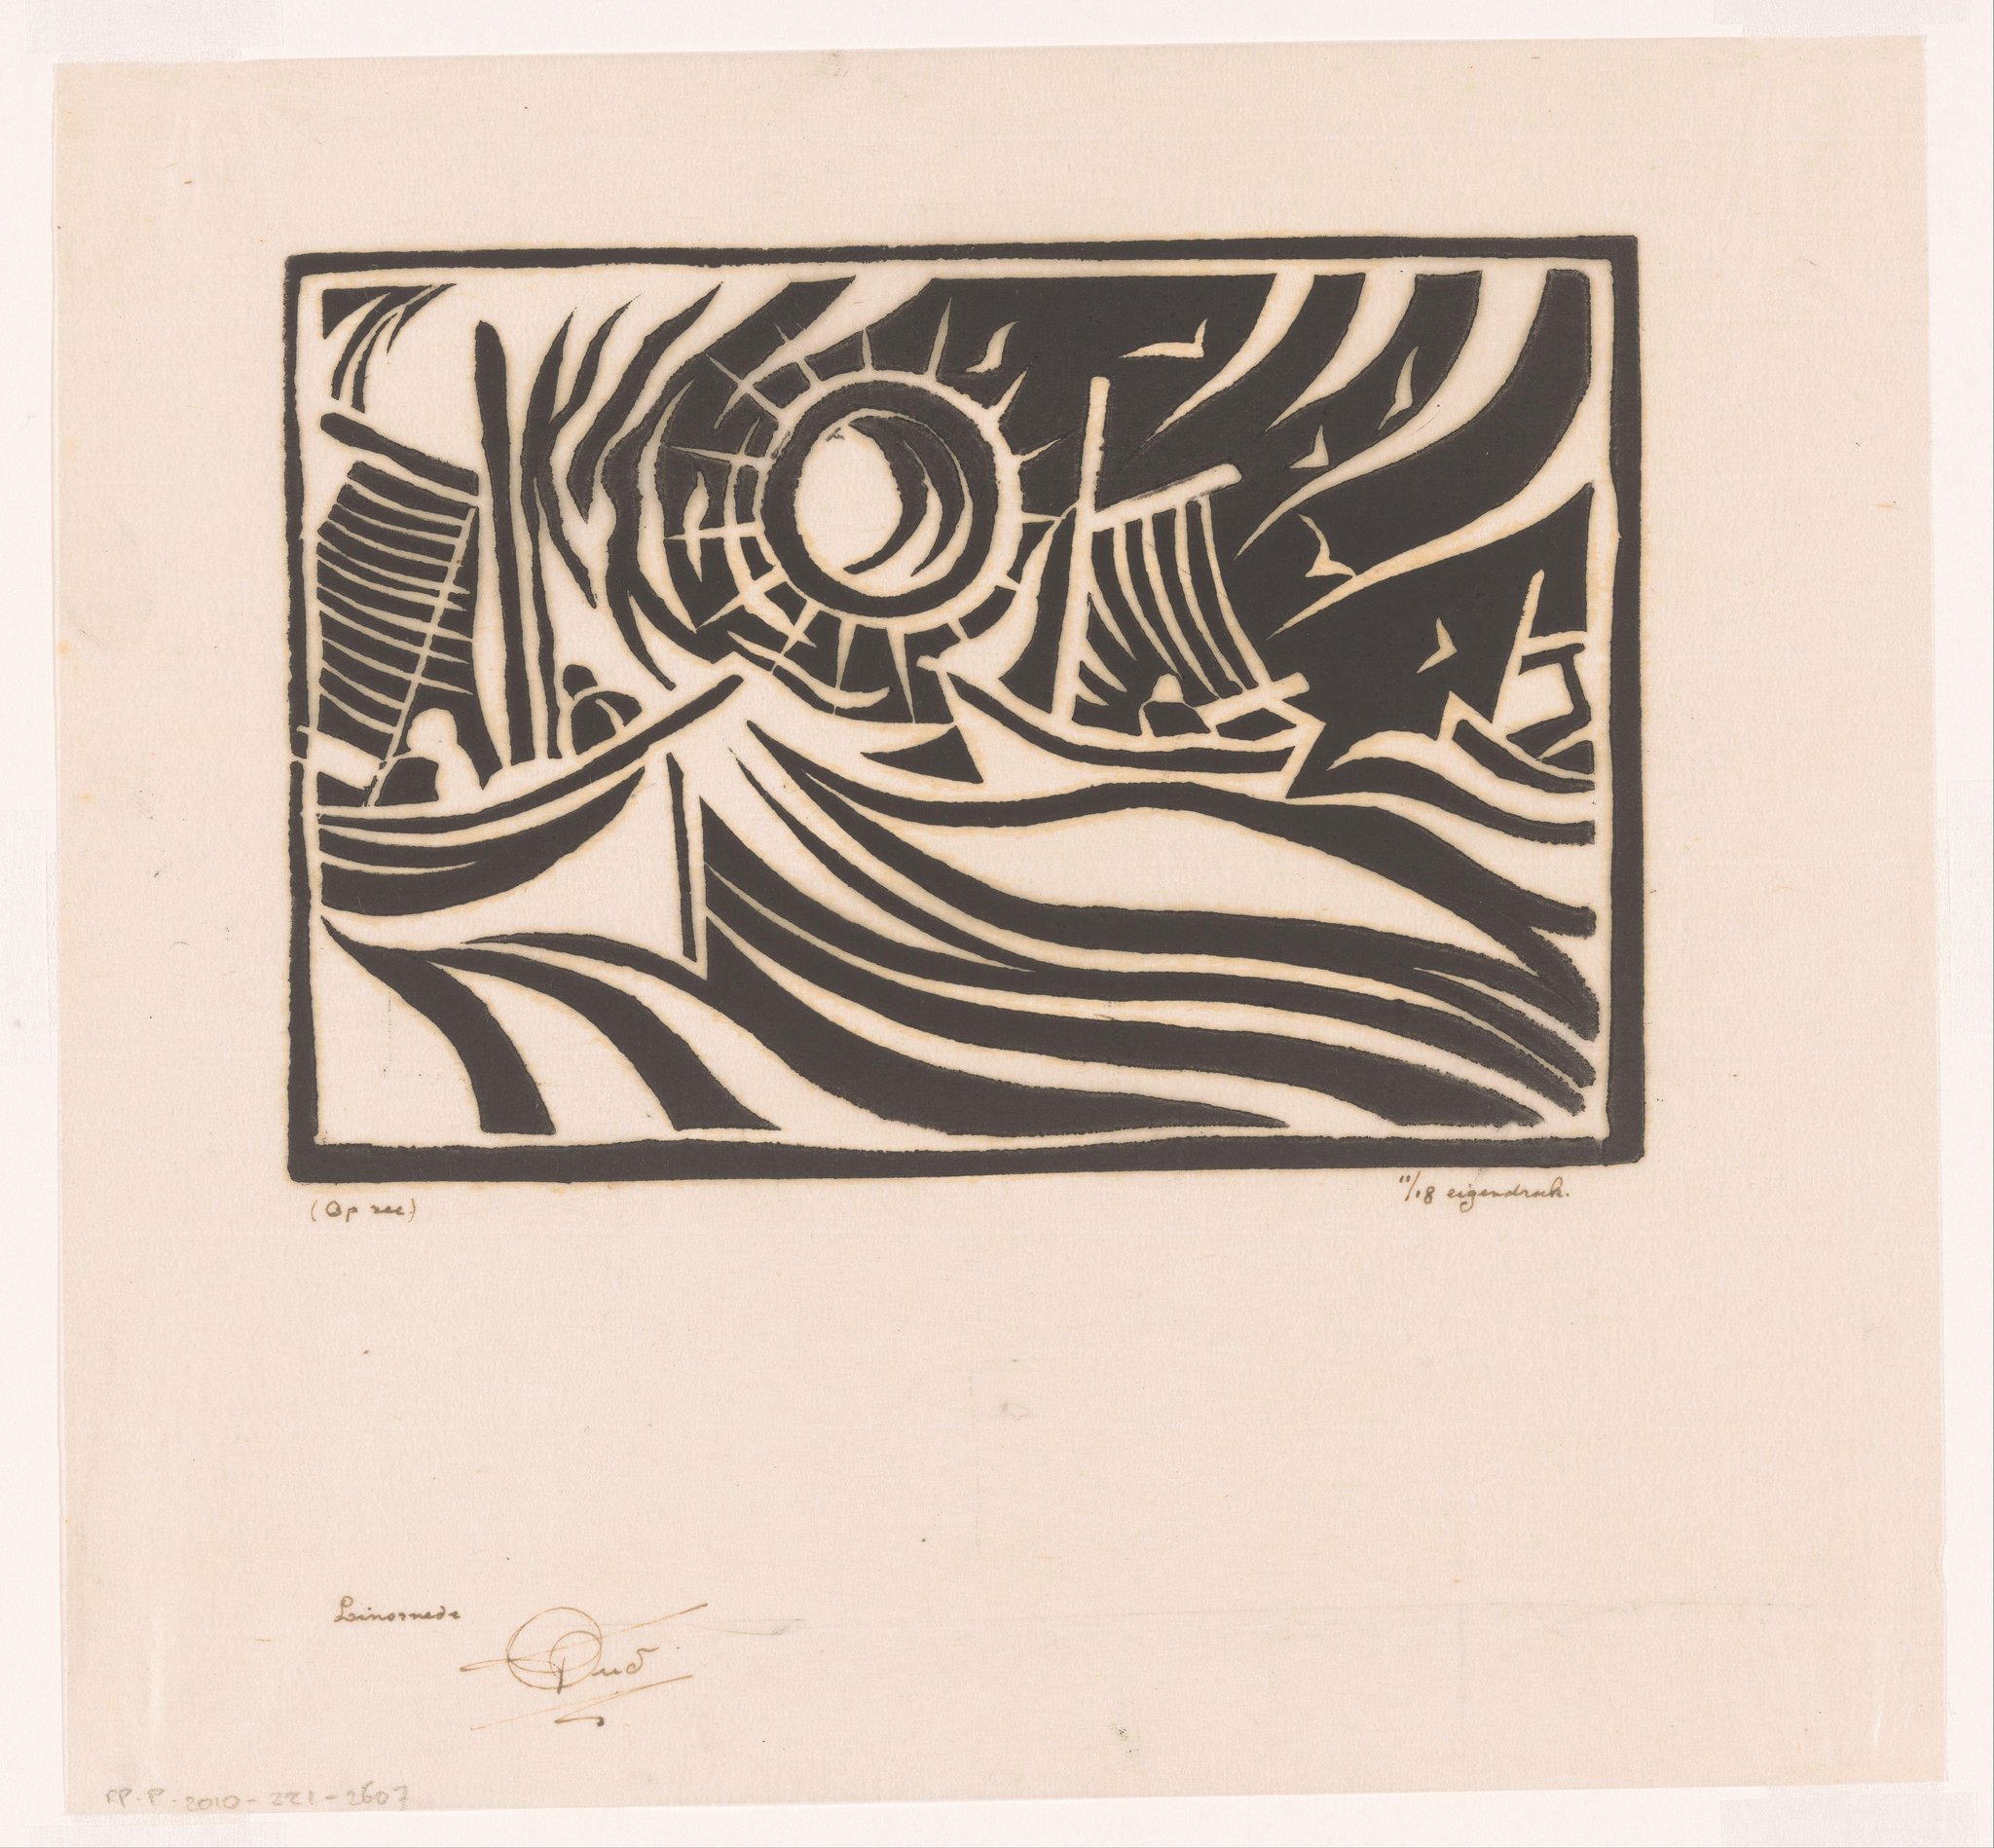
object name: print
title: Op zee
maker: tames oud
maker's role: print maker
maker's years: 1895-1953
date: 1950-1953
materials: paper, ink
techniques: linocut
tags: sailing-ship, sailing-boat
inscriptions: edition: ‘11/18 eigendruk.’, signature: ‘Linosnede/ TOud’, title: ‘(Op zee)’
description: Twee zeilschepen op een woelige zee met een laagstaande zon en vliegende meeuwen.